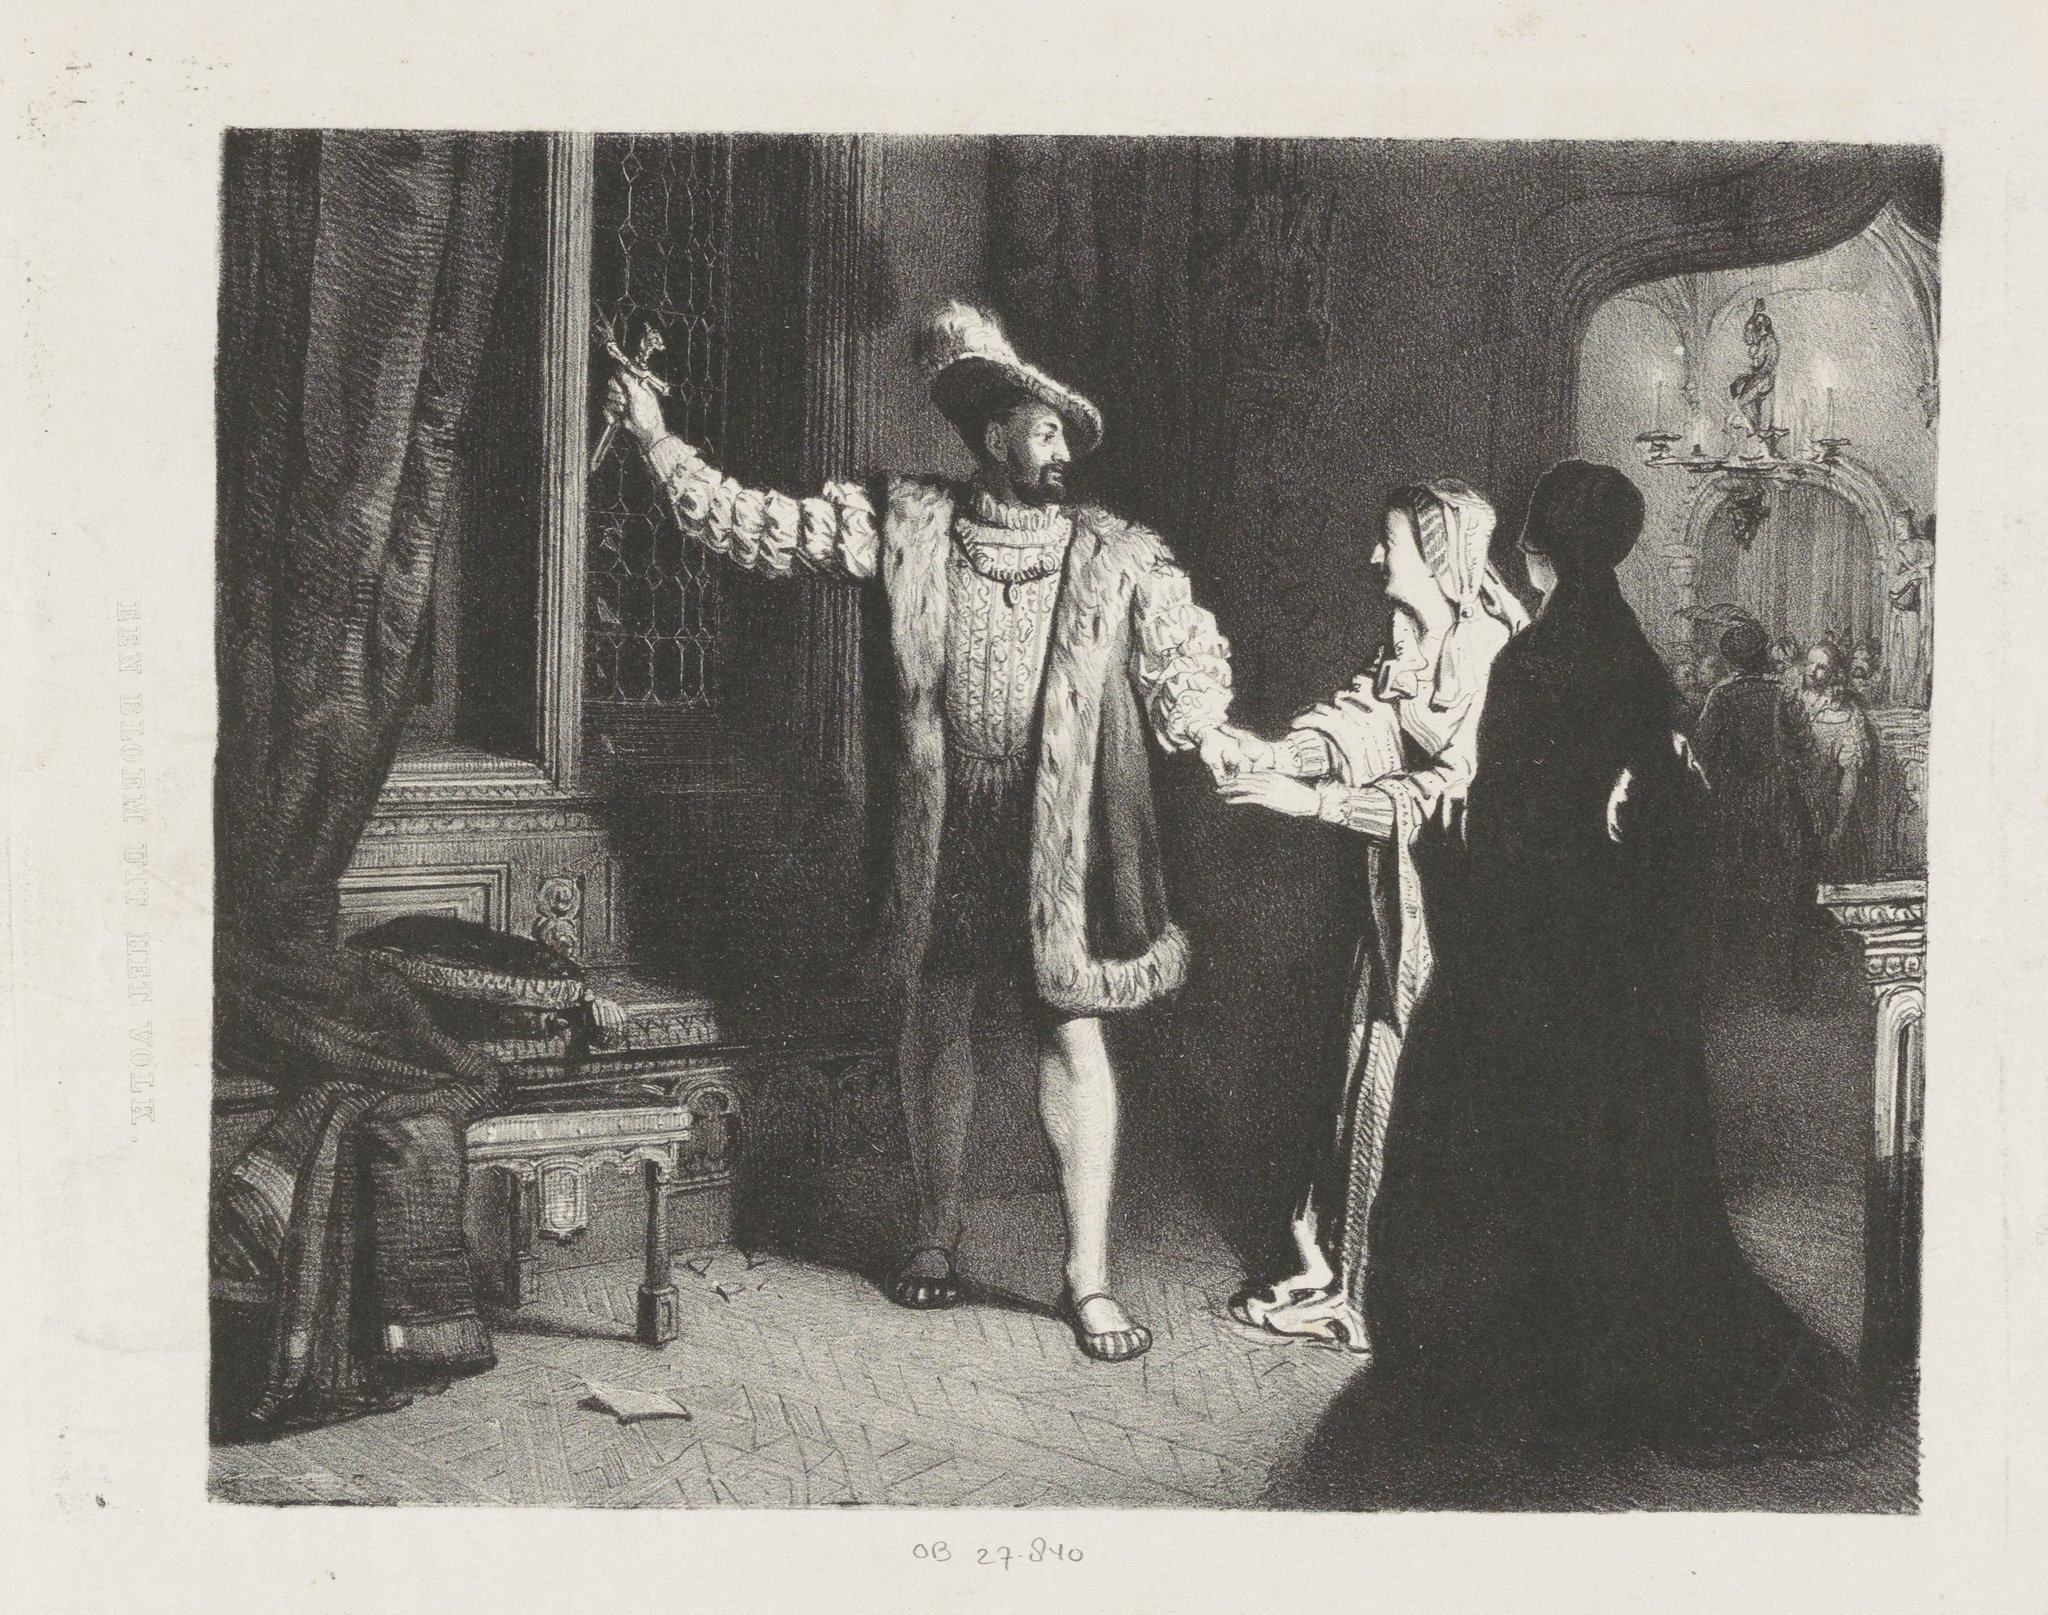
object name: print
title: Frans de Eersten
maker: reinier craeyvanger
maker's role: draughtsman, print maker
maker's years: 1812-1880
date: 1822-1880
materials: paper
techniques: lithograph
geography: netherlands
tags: frans i van valois-angoulême (koning van frankrijk), hacking and thrusting weapons: dagger, historical persons, open window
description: Scène uit het leven van koning Frans I van Frankrijk. De koning staat met twee dames bij een open raam. Zijn rechterhand, met daarin een dolk, houdt hij omhoog. Links naast de afbeelding staan, verticaal, de woorden: 'een bloem uit het volk'.